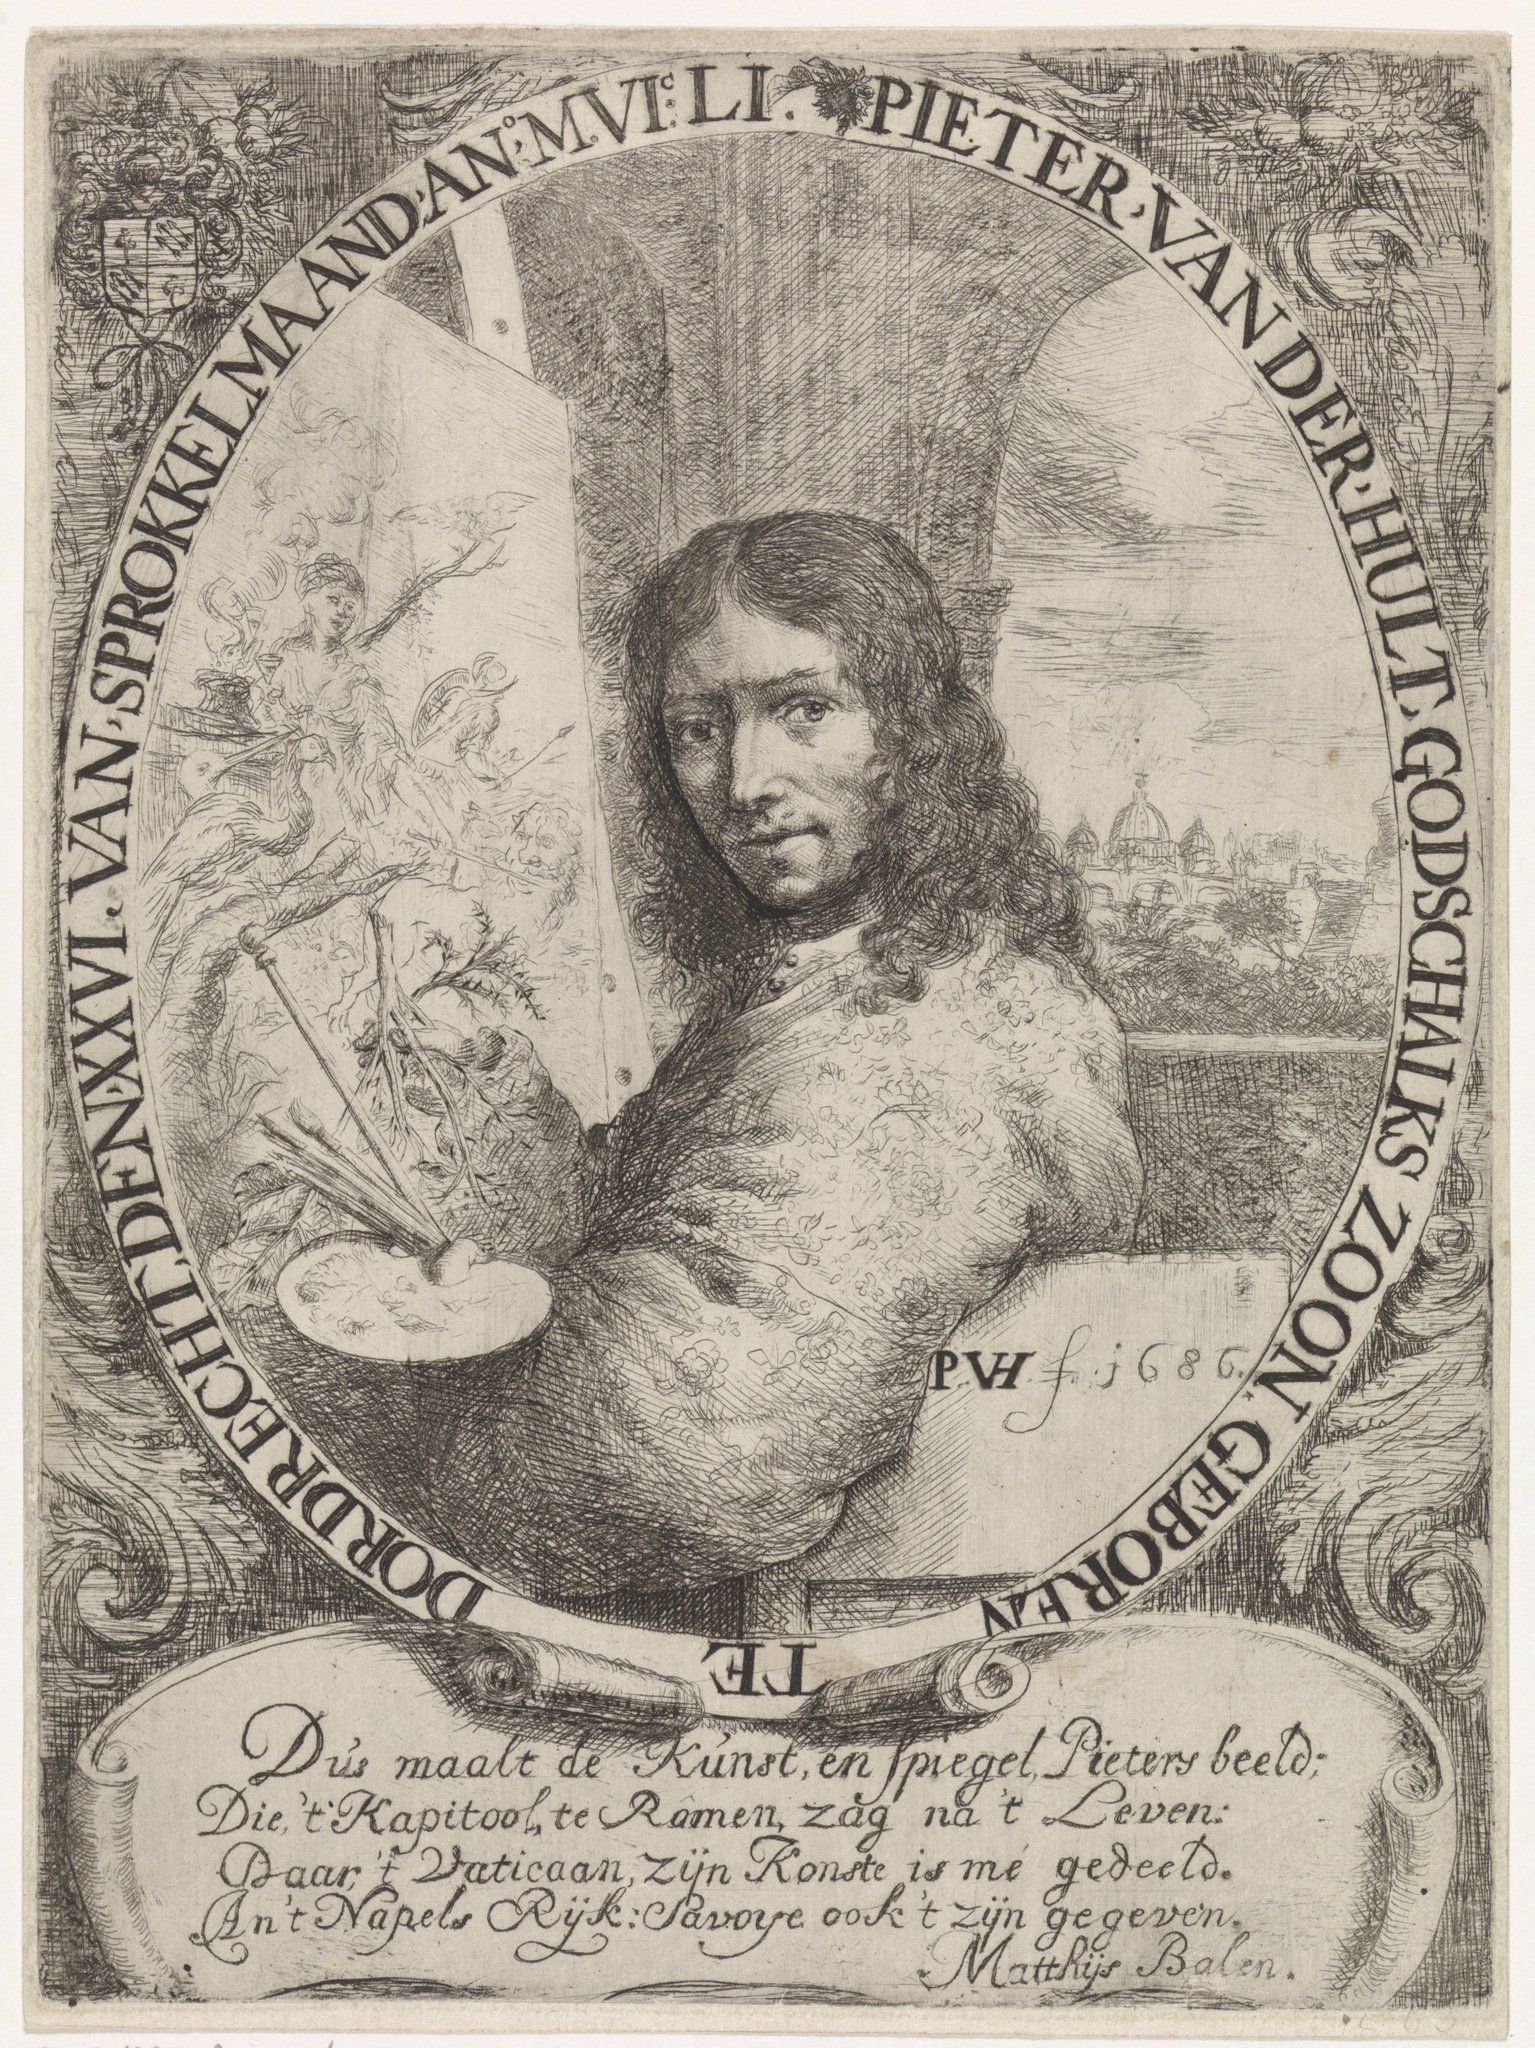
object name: print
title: Zelfportret van Pieter van der Hulst (IV)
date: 1686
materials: paper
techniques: engraving, etching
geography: dordrecht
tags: dordrecht, print maker, pieter van der hulst (iv)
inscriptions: collector's mark: Lugt 2228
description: Pieter van der Hulst ten halven lijve naar links, zittend voor een schilderij. In zijn hand houdt hij een palet, penselen en schilderstok. Rechts door het venster uitzicht op de stad Rome. Portret in een ovaal met randschrift in het Nederlands. Onderaan een vierregelige tekst op een cartouche in het Nederlands.